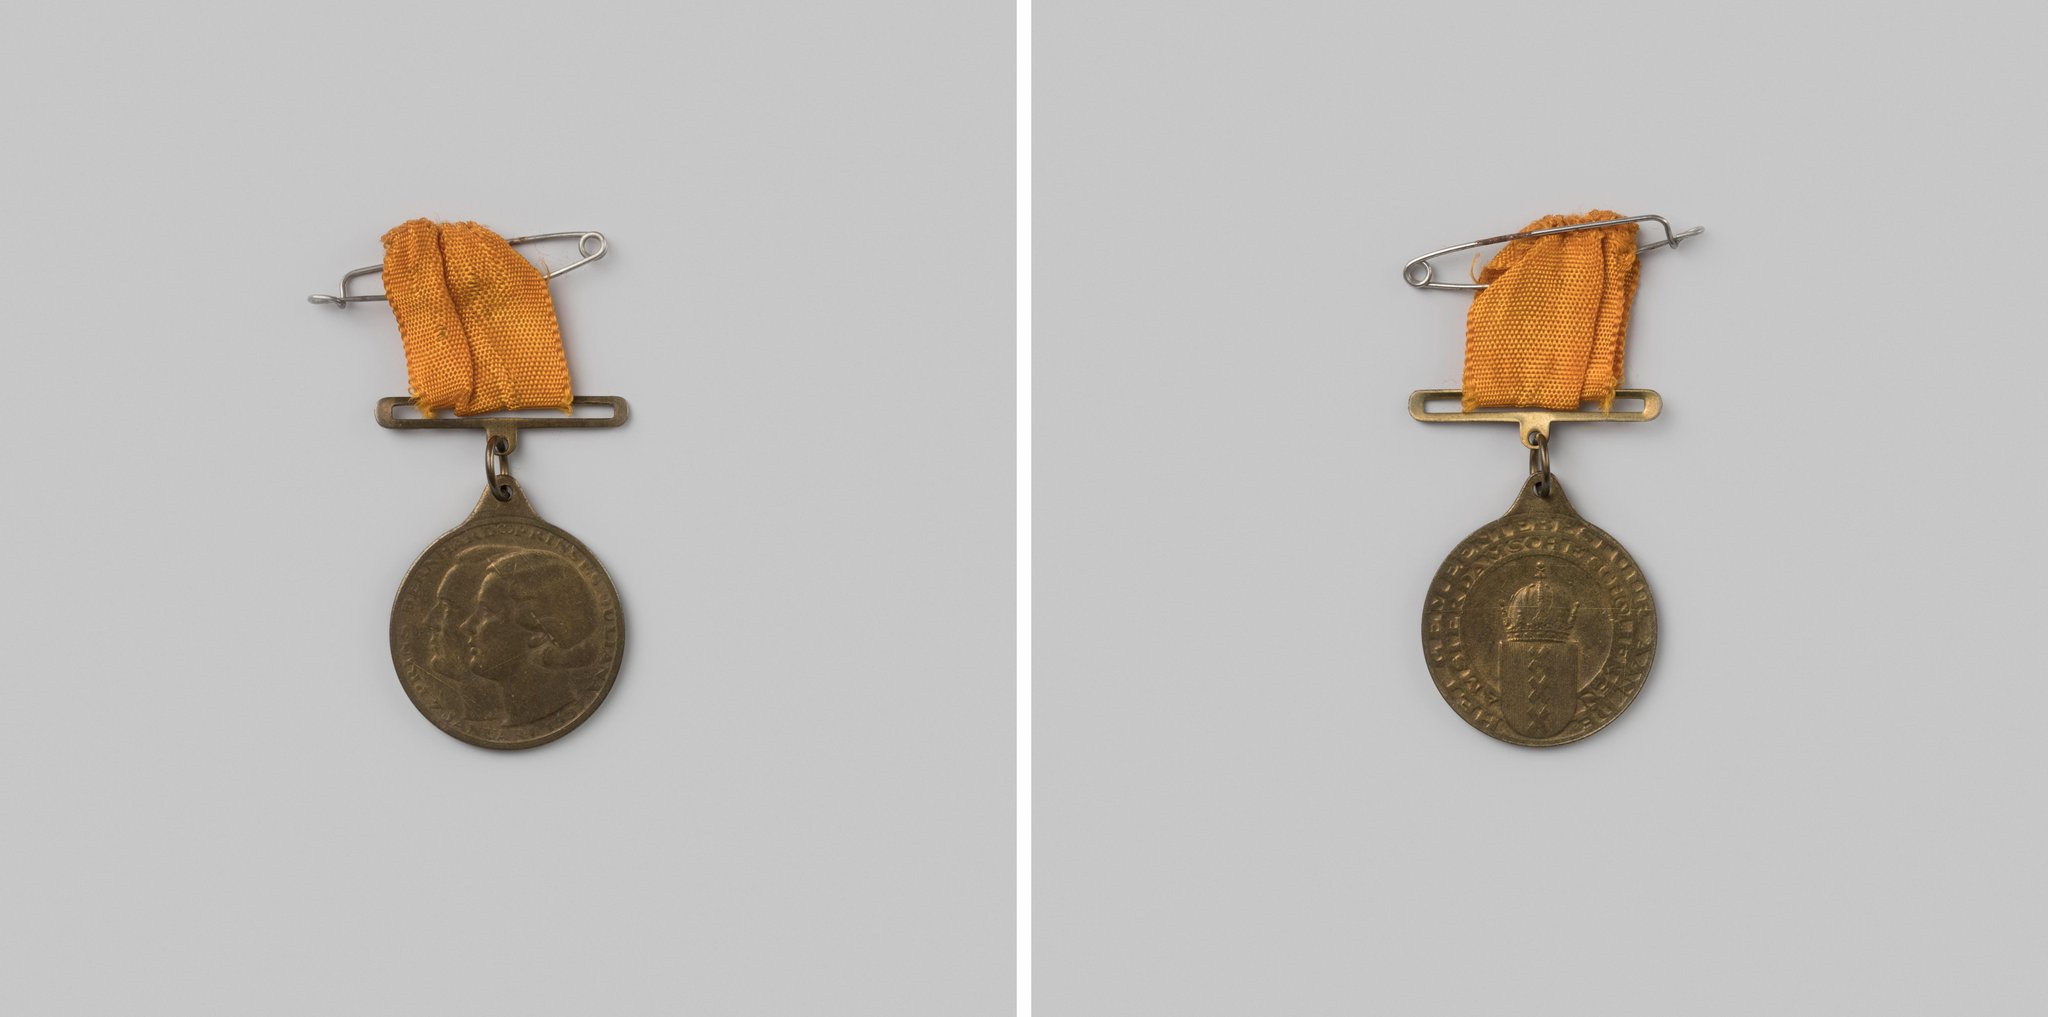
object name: insignia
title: Huwelijk van Juliana, prinses der Nederlanden en Bernhard, prins van Lippe-Biesterfeld, penning door het stadsbestuur van Amsterdam aan de scholieren geschonken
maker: Anonymous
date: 1937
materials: bronze, textile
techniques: sewing, striking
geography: netherlands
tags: utrecht, bernhard (prins der nederlanden), the hague, juliana of the netherlands, amsterdam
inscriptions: circumscription: ‘PRINS BERNHARD - PRINSES JULIANA’, inscription: ‘HET GEMEENTEBESTUUR AAN DE AMSTERDAMSCHE SCHOLIEREN’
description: Bronzen penning aan draagoog, draagring en langwerpig hangertje, waar oranje lint door is gestoken. Voorzijde: borststuk man en vrouw binnen omschrift. Keerzijde: gekroond wapenschild binnen tweeregelig omschrift.